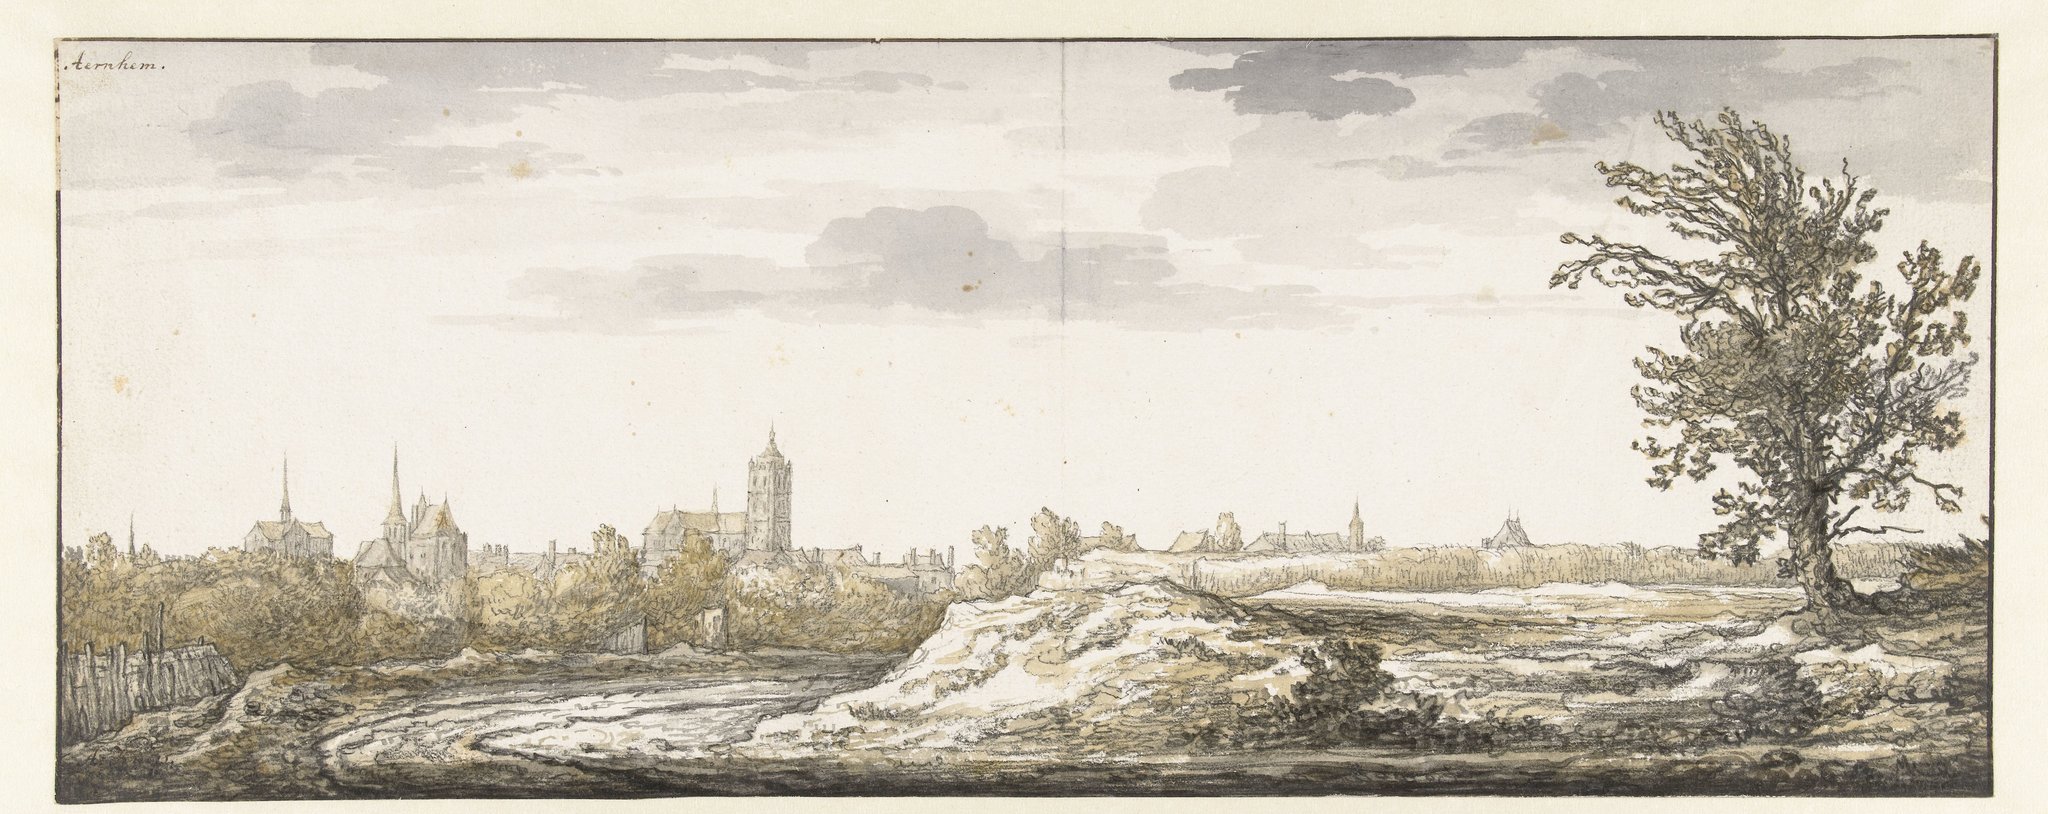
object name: drawing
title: Arnhem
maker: aelbert cuyp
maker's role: draughtsman, painter, print maker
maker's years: 1620-1691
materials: chalk, gum arabic, paper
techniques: brush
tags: arnhem